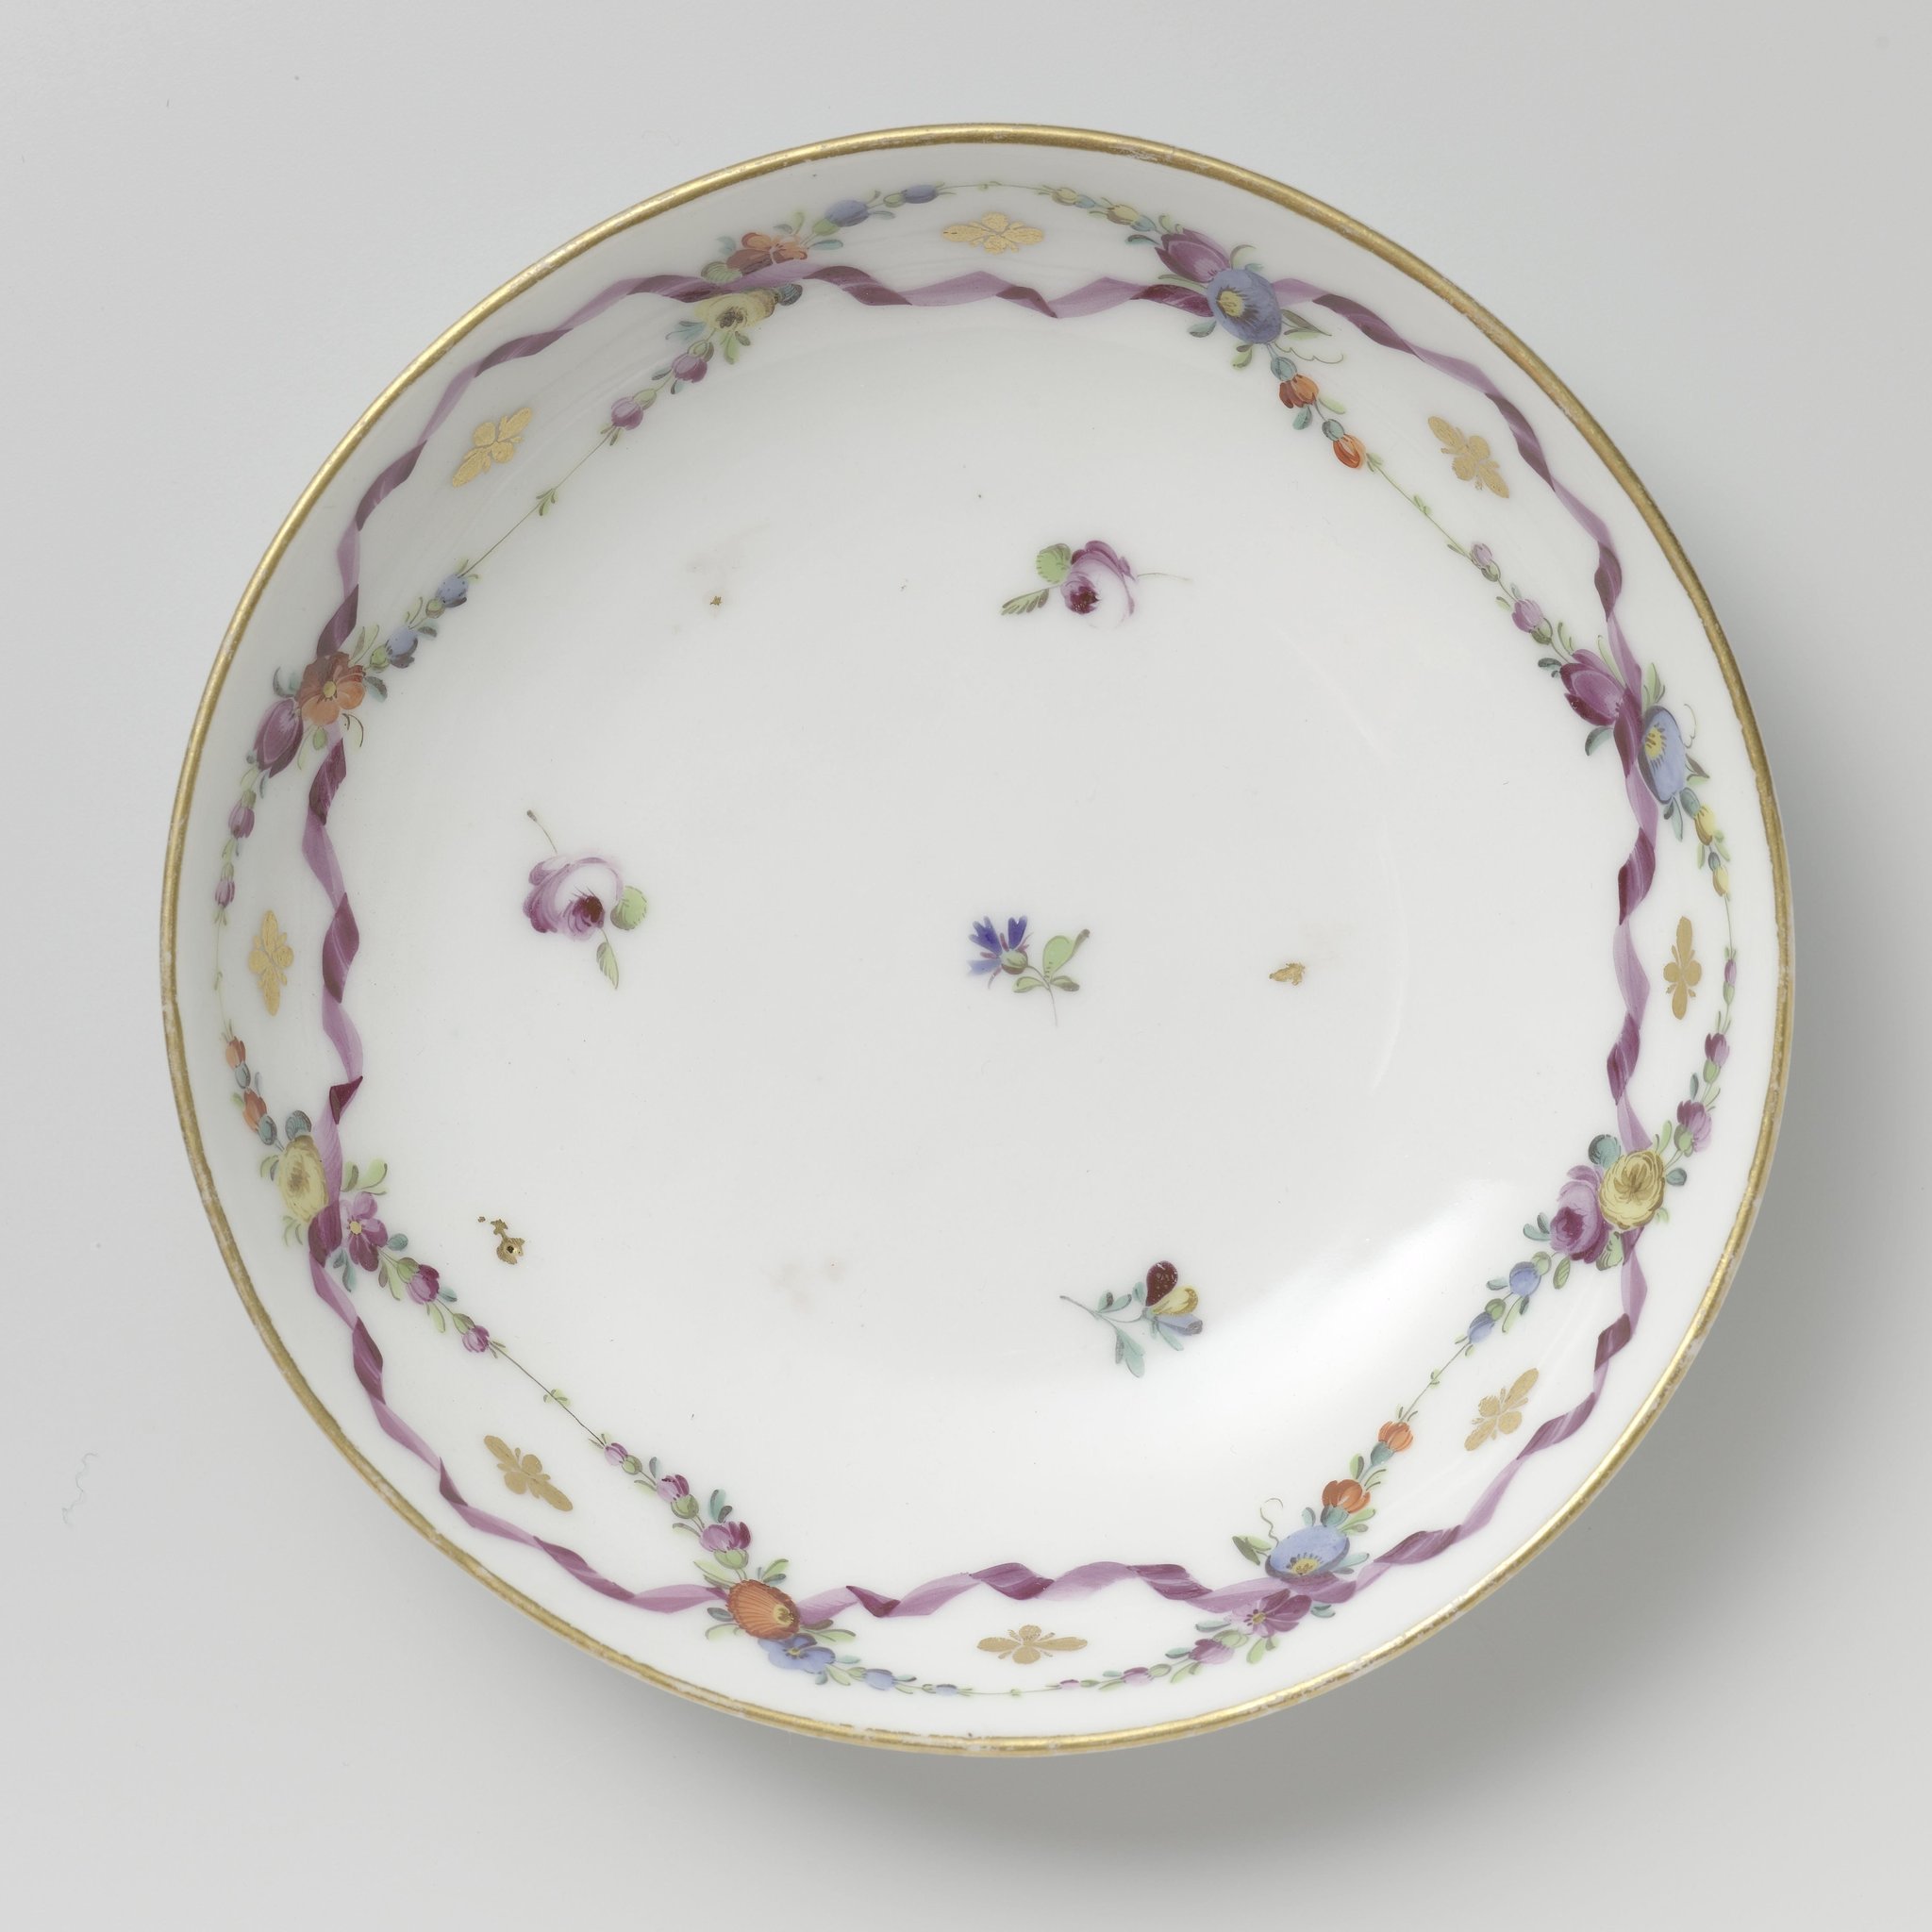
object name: platter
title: Schotel, beschilderd met strooibloemen en gouden lovertjes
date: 1809-1814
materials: porcelain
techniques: painted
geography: nieuwer-amstel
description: Tea service. Porcelain. Ouder-Amstel, c. 1790 - 1800. Factory under the direction of Friedrich Daeuber. Given by Mr and Mrs J.F. Heijbroek-Leendertz, 1985.